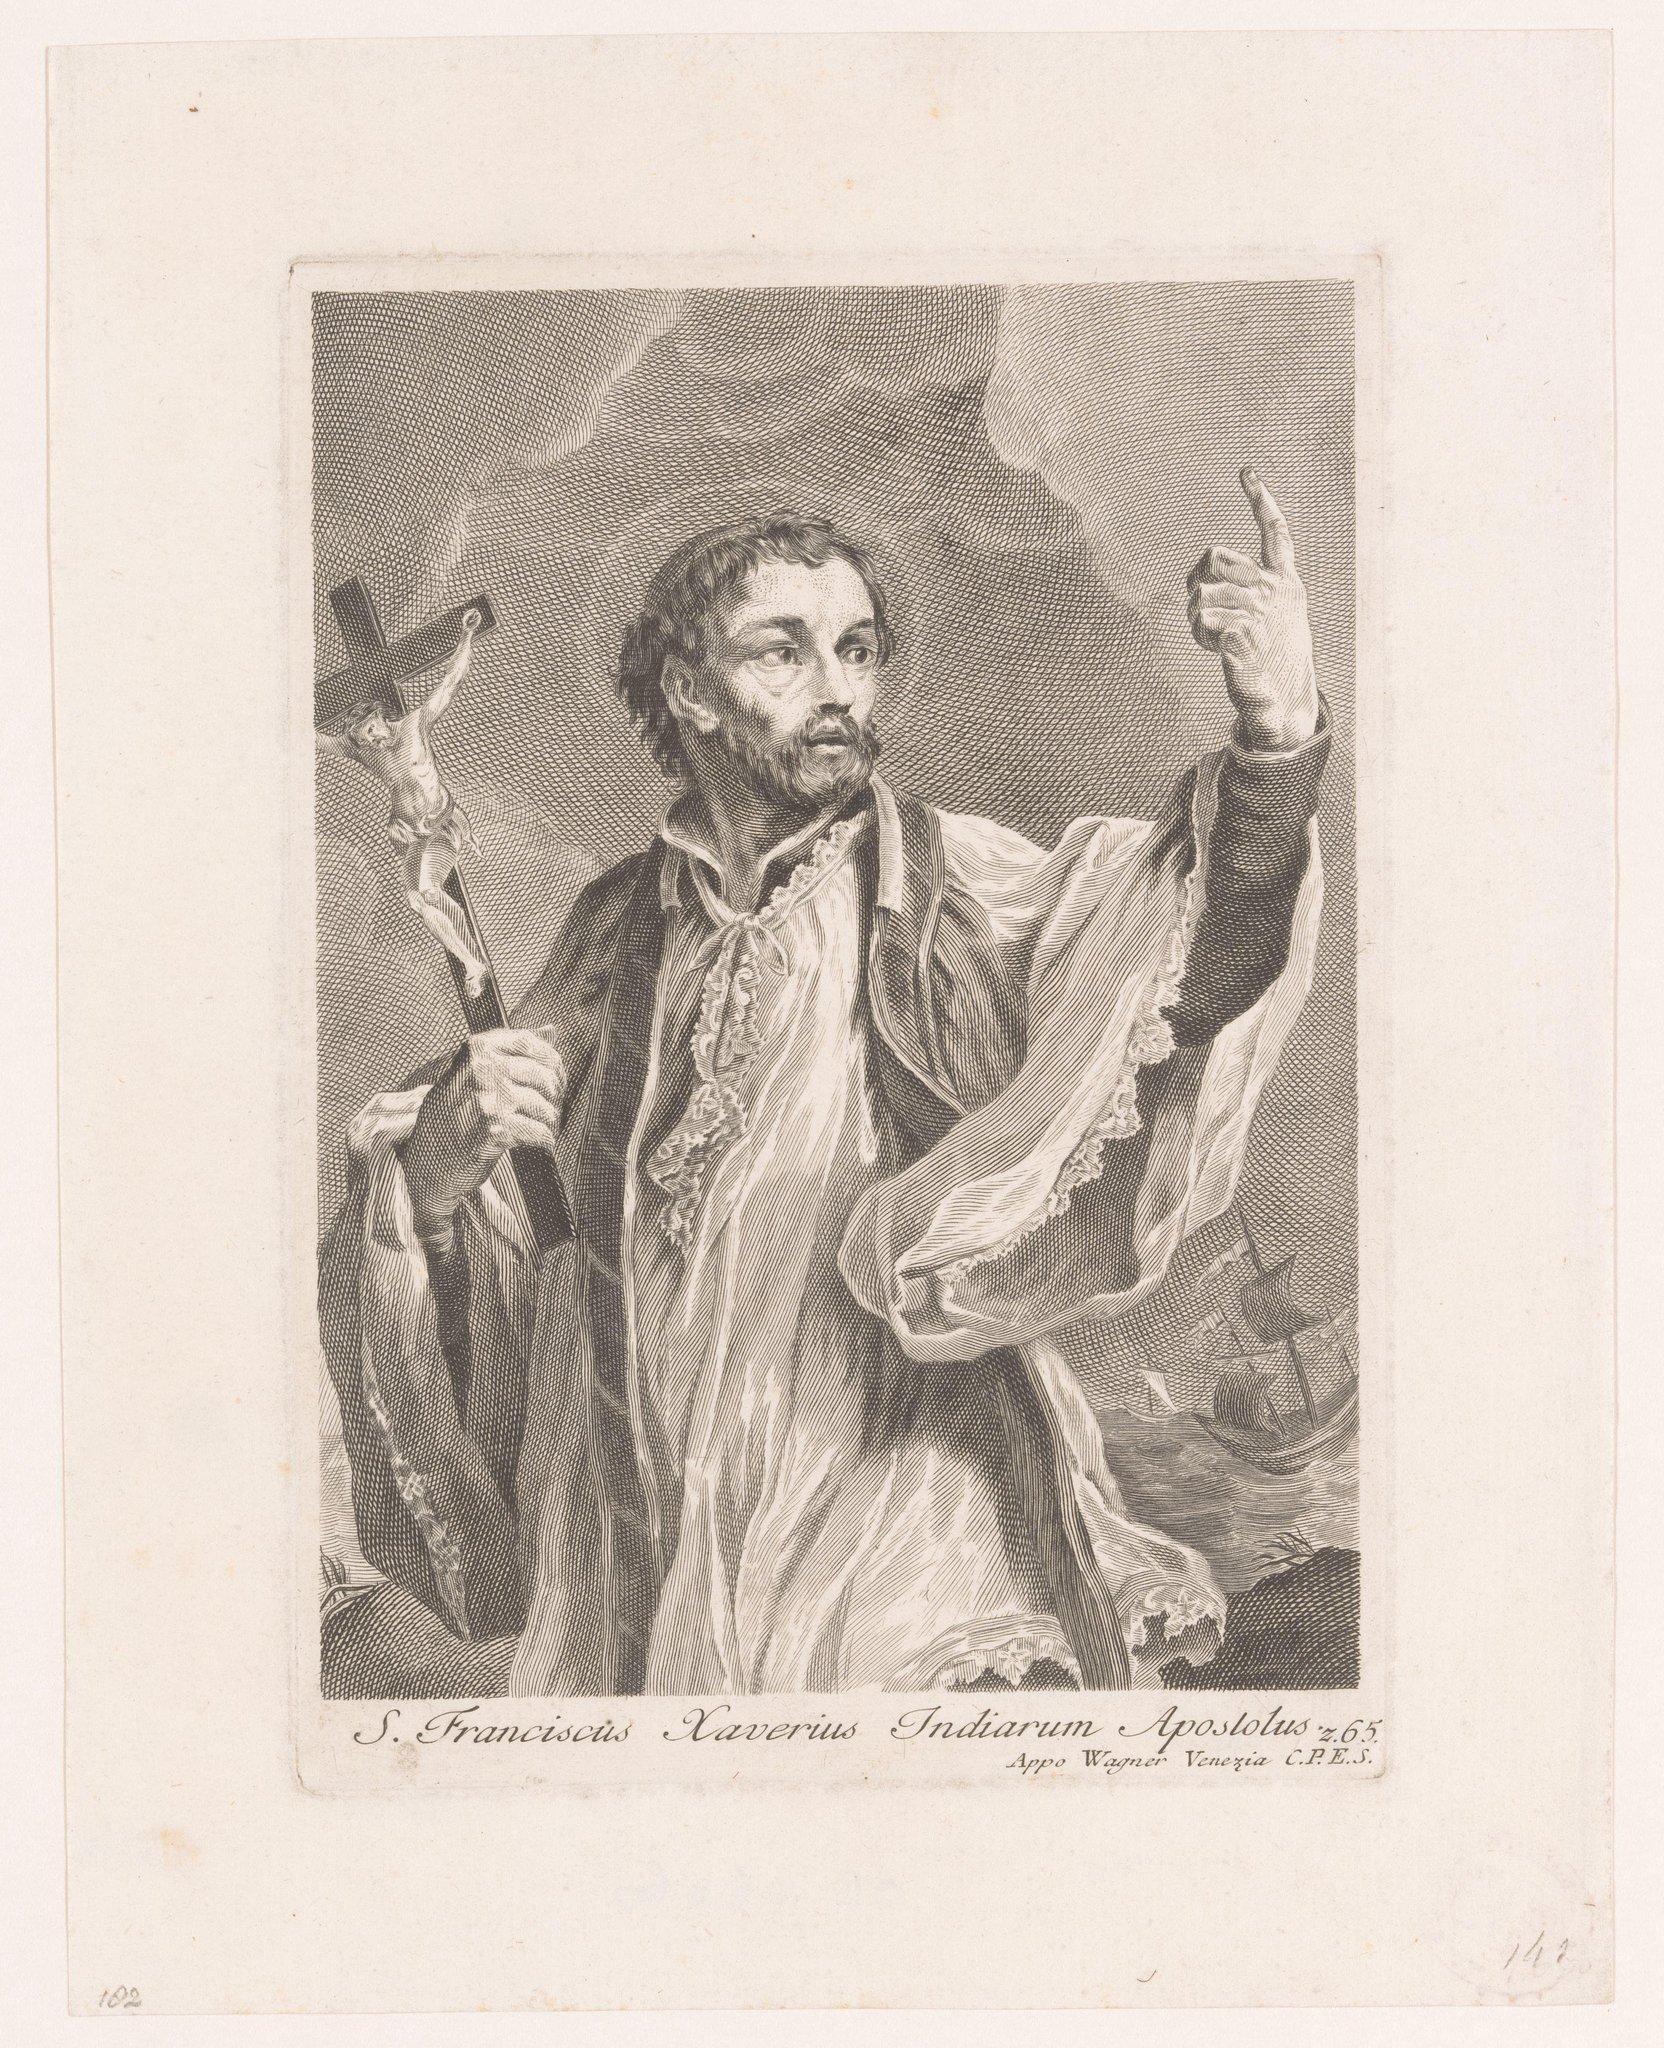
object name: print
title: S. Franciscus Xaverius Indiarum Apostolus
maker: joseph wagner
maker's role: painter, print maker, publisher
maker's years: 1706-1780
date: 1739-1780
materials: paper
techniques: etching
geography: venice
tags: crucifix ~ personal devotion, the jesuit missionary francis xavier; possible attributes: cross, crucifix, flaming heart, indian, lily, torch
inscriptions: collector's mark: Lugt 240